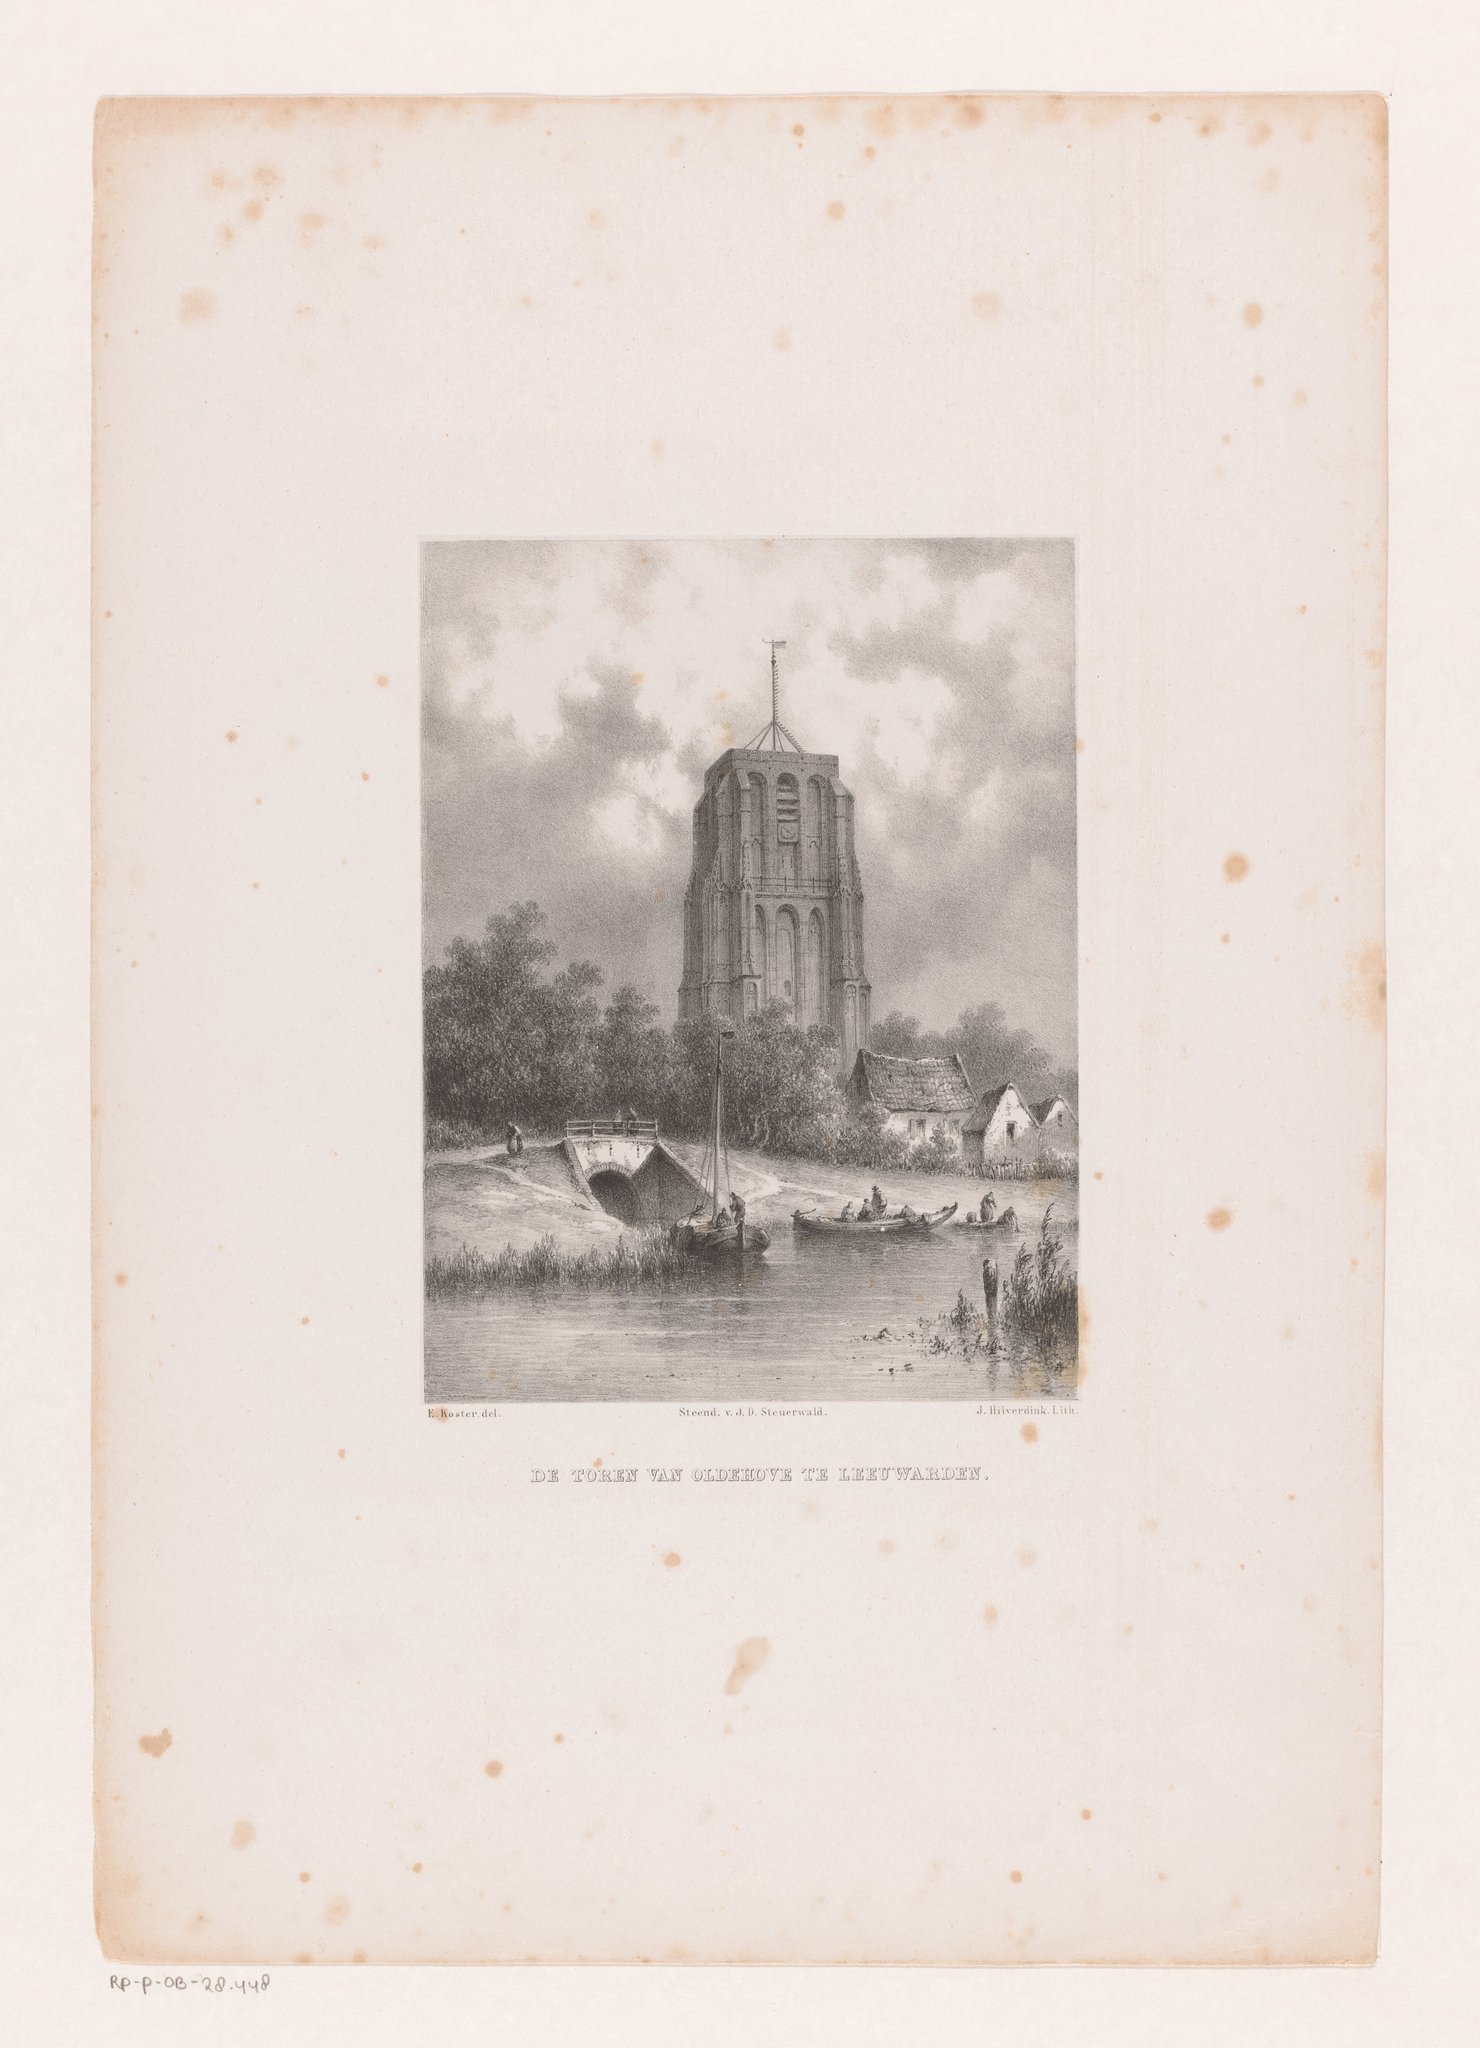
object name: print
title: Oldehove in Leeuwarden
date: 1858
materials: paper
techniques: lithograph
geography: amsterdam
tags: city-view, and landscape with man-made constructions (+ city(-scape) with figures, staffage), parts of church exterior and annexes: tower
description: Deze prent komt uit: Koster, E. 'E. Koster's schetsboek: Nederlandsche Stads- en Havengezichten, uitgegeven onder medewerking van de maatschappij Arti et Amicitiae, Amsterdam, F. Buffa en Zn., e.a.' Amsterdam 1858.